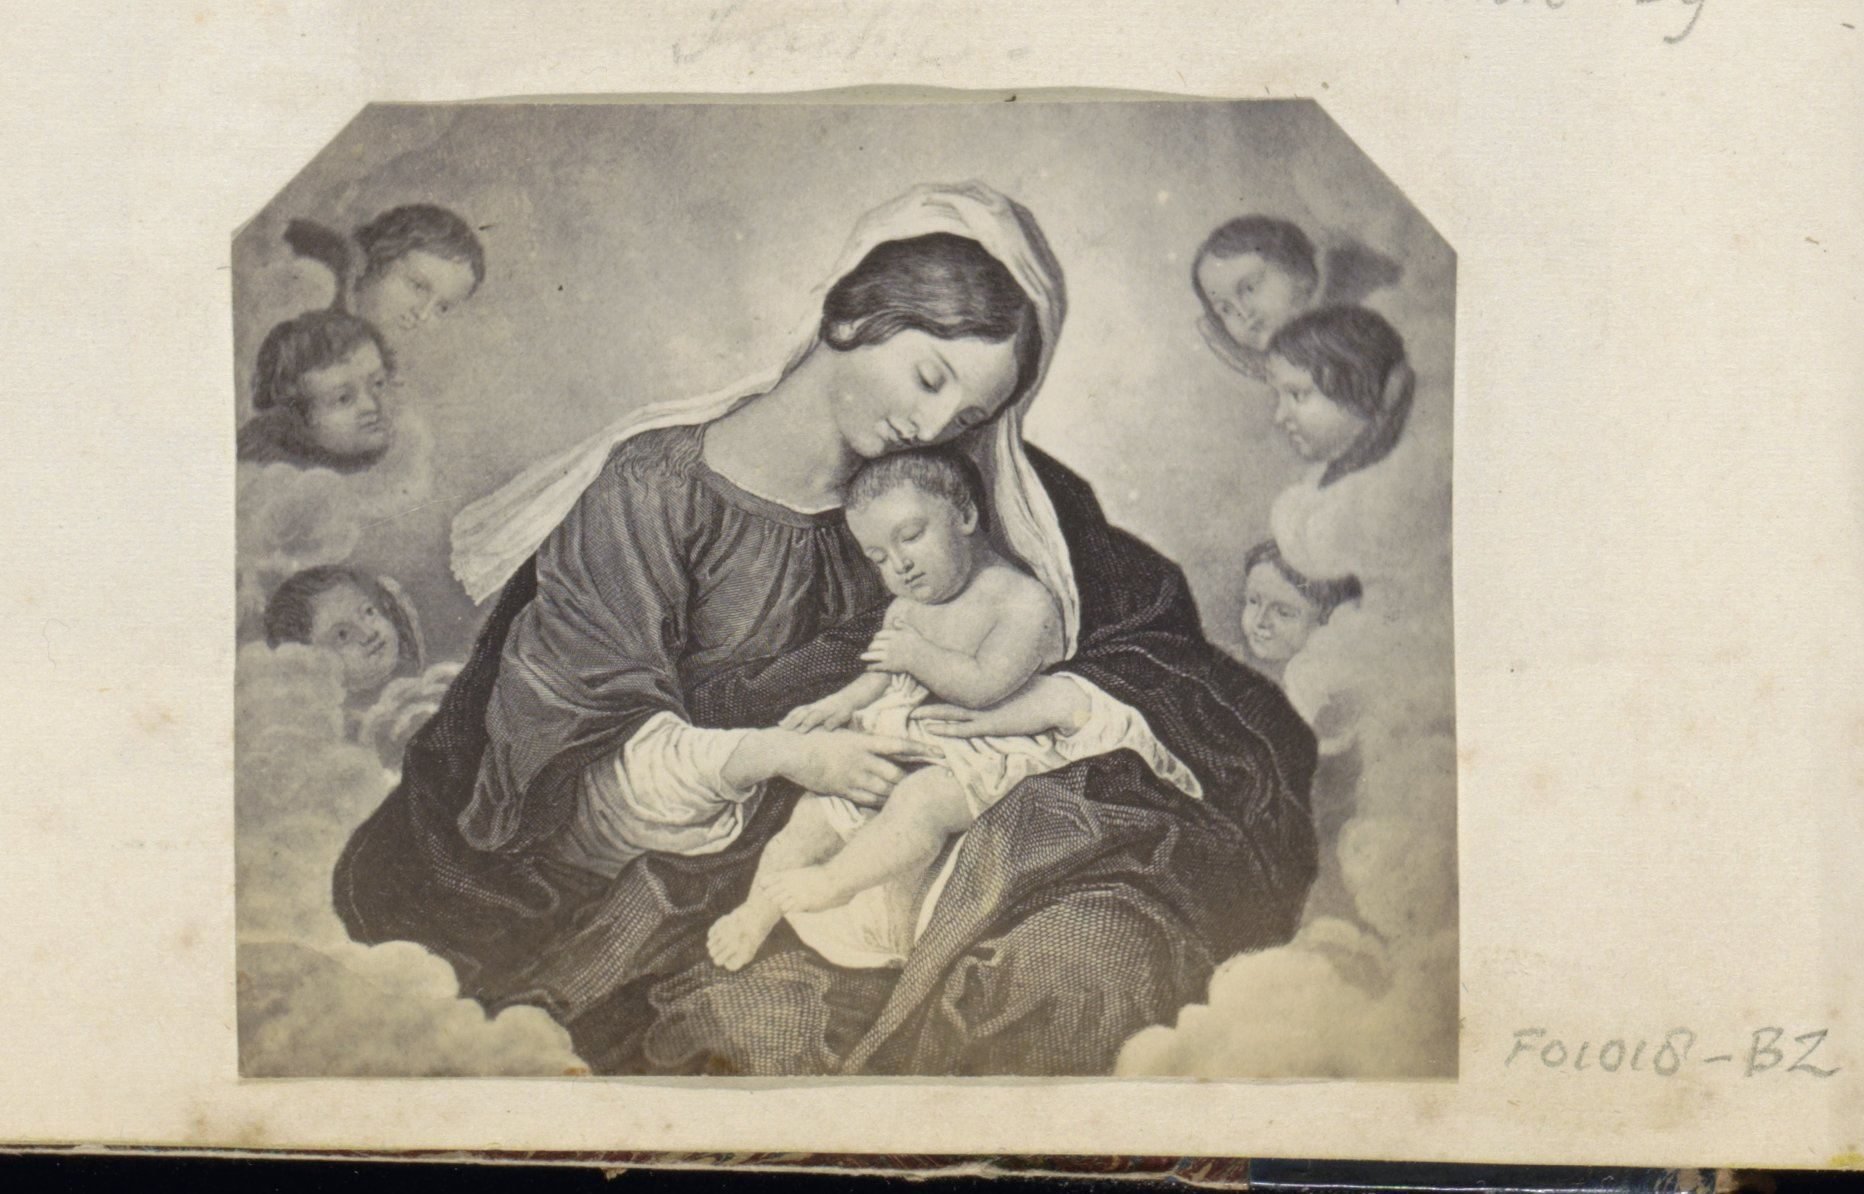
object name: reproduction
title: Fotoreproductie van (vermoedelijk) een prent met Maria en het kind Jezus omringd door engelen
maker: Anonymous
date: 1860-1870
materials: paper, photographic support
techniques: albumen print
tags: specific types of madonna with others (+ angels floating in the air)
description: Onderdeel van Engels familiealbum met foto's van personen, reizen, cricket en kunstwerken.